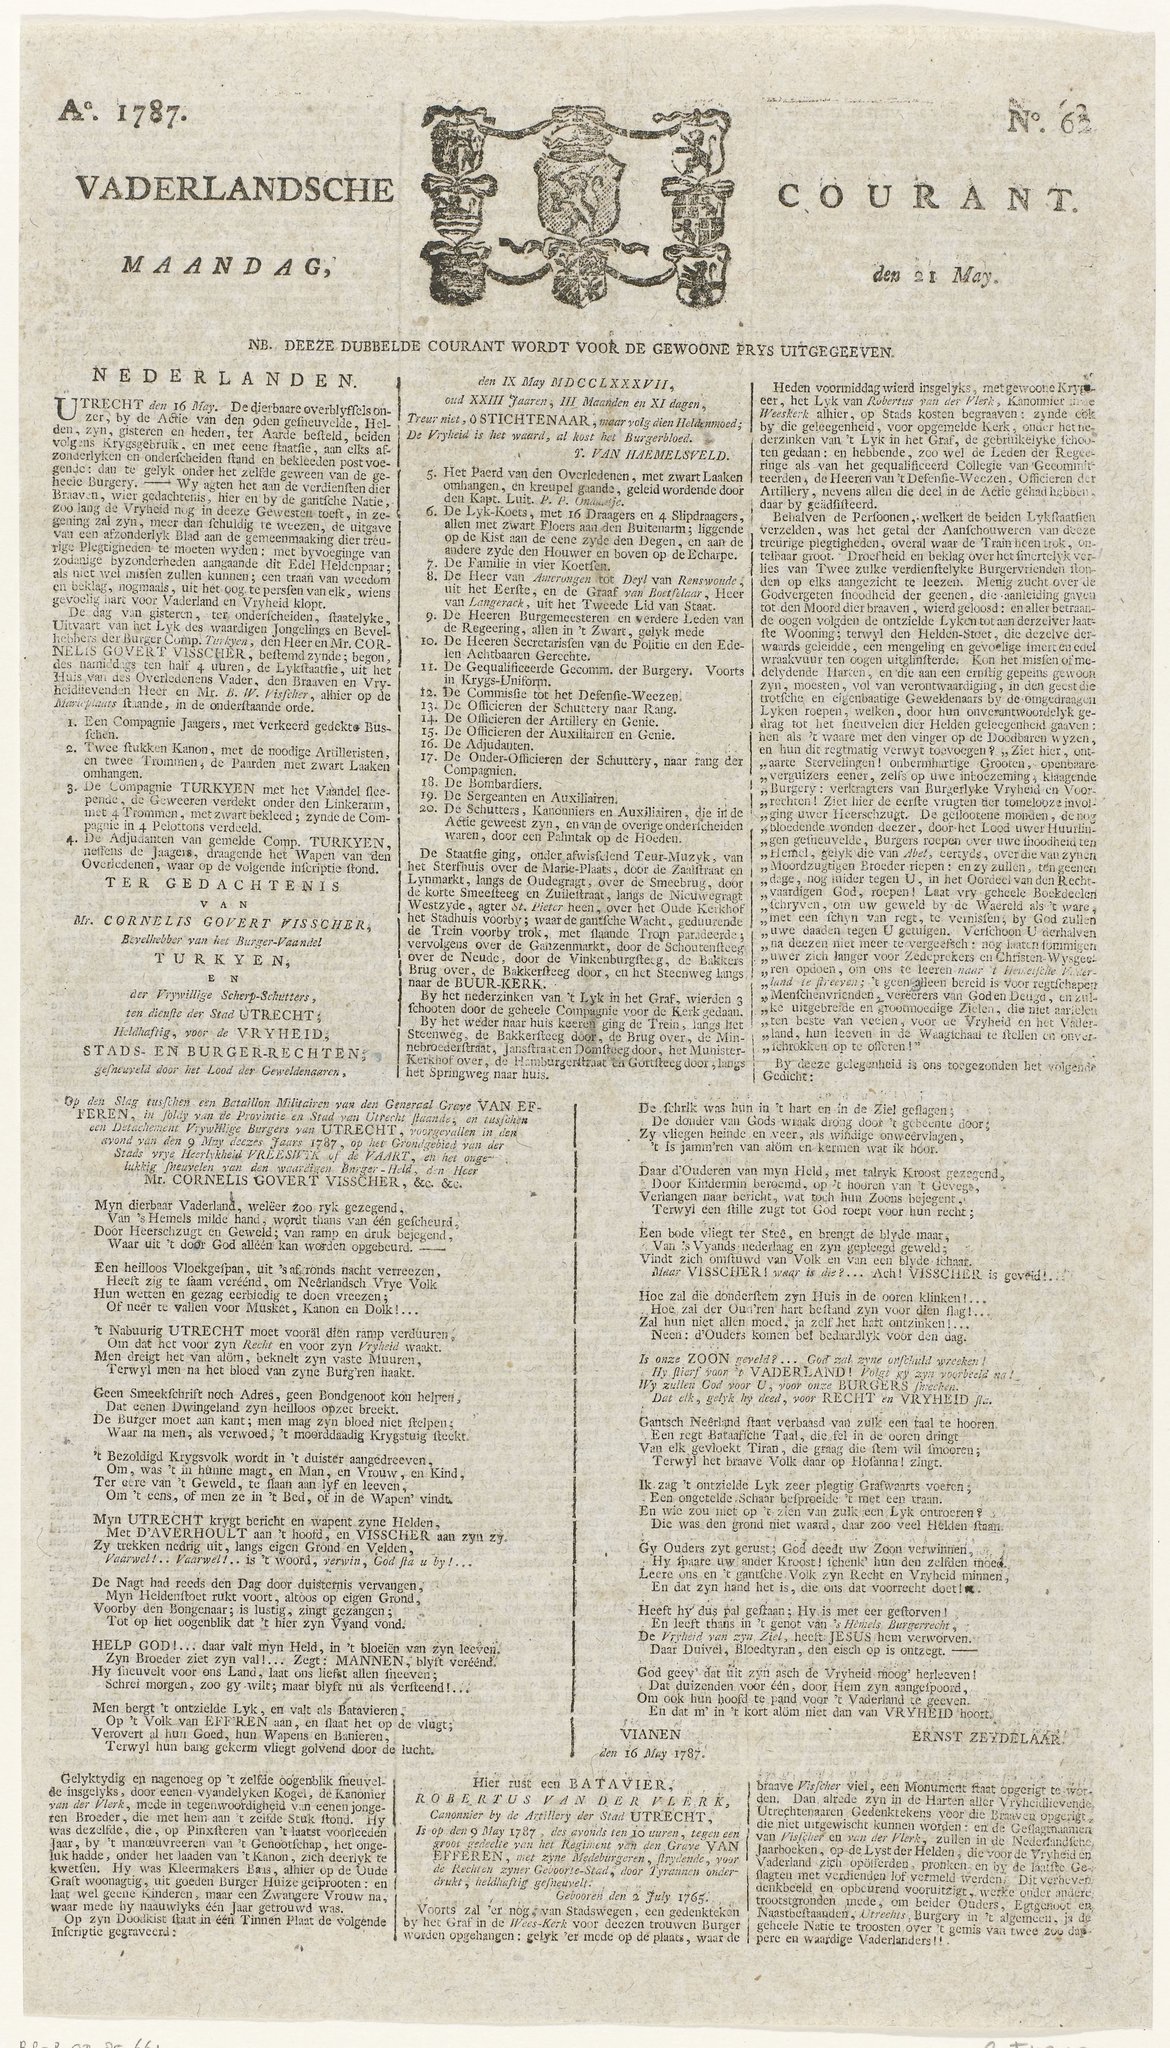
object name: newspaper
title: Vaderlandsche Courant. Maandag, den 21 May. Ao. 1787. No. 62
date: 1787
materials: paper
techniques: letterpress printing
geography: northern netherlands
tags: utrecht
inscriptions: collector's mark: Lugt 2228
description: Aflevering nr. 62 van de Vaderlandsche Courant van 21 mei 1787 met een verslag van de begrafenis van Cornelis Govert Visscher (gesneuveld in het gevecht bij Vreeswijk op 9 mei) te Utrecht op 15 mei 1787. Blad met tekst in drie en twee kolommen, bovenaan de wapens van de Republiek. Blad bedrukt op beide zijden.